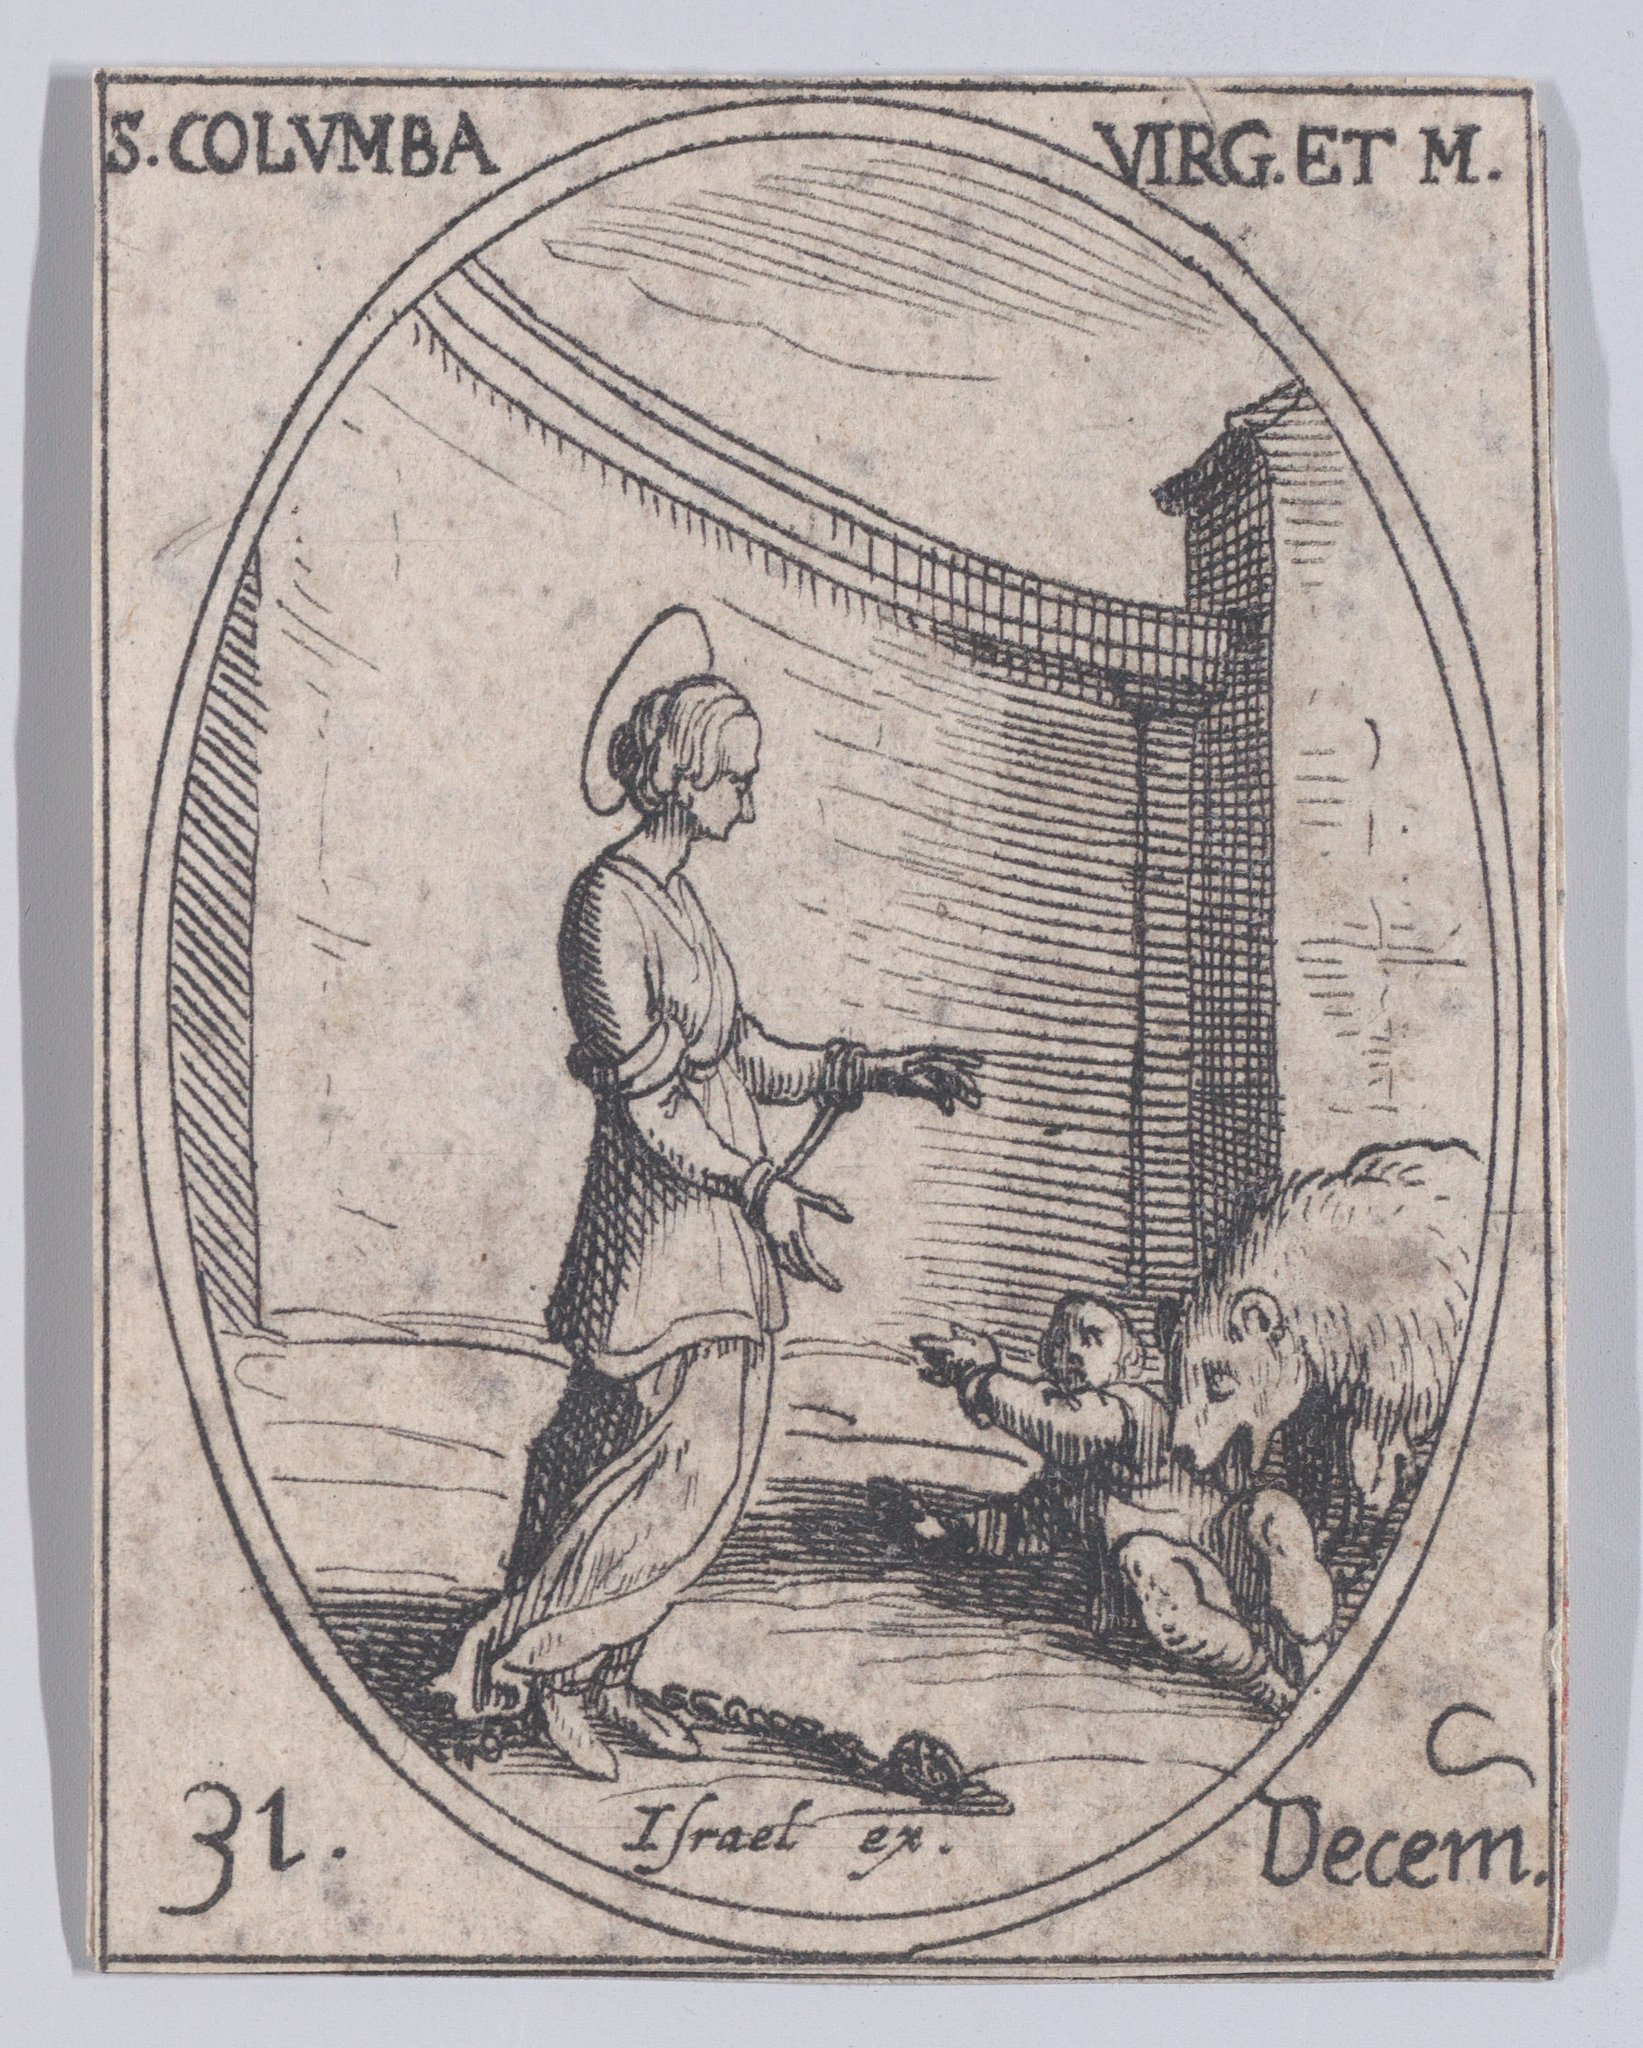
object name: print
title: Ste. Columbe, vierge et martyre (St. Columba, Virgin and Martyr), December 31st, from "Les Images De Tous Les Saincts et Saintes de L'Année" (Images of All of the Saints and Religious Events of the Year)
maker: jacques callot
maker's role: artist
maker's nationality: french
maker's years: 1592-1635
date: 1636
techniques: etching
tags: bears,women,saints